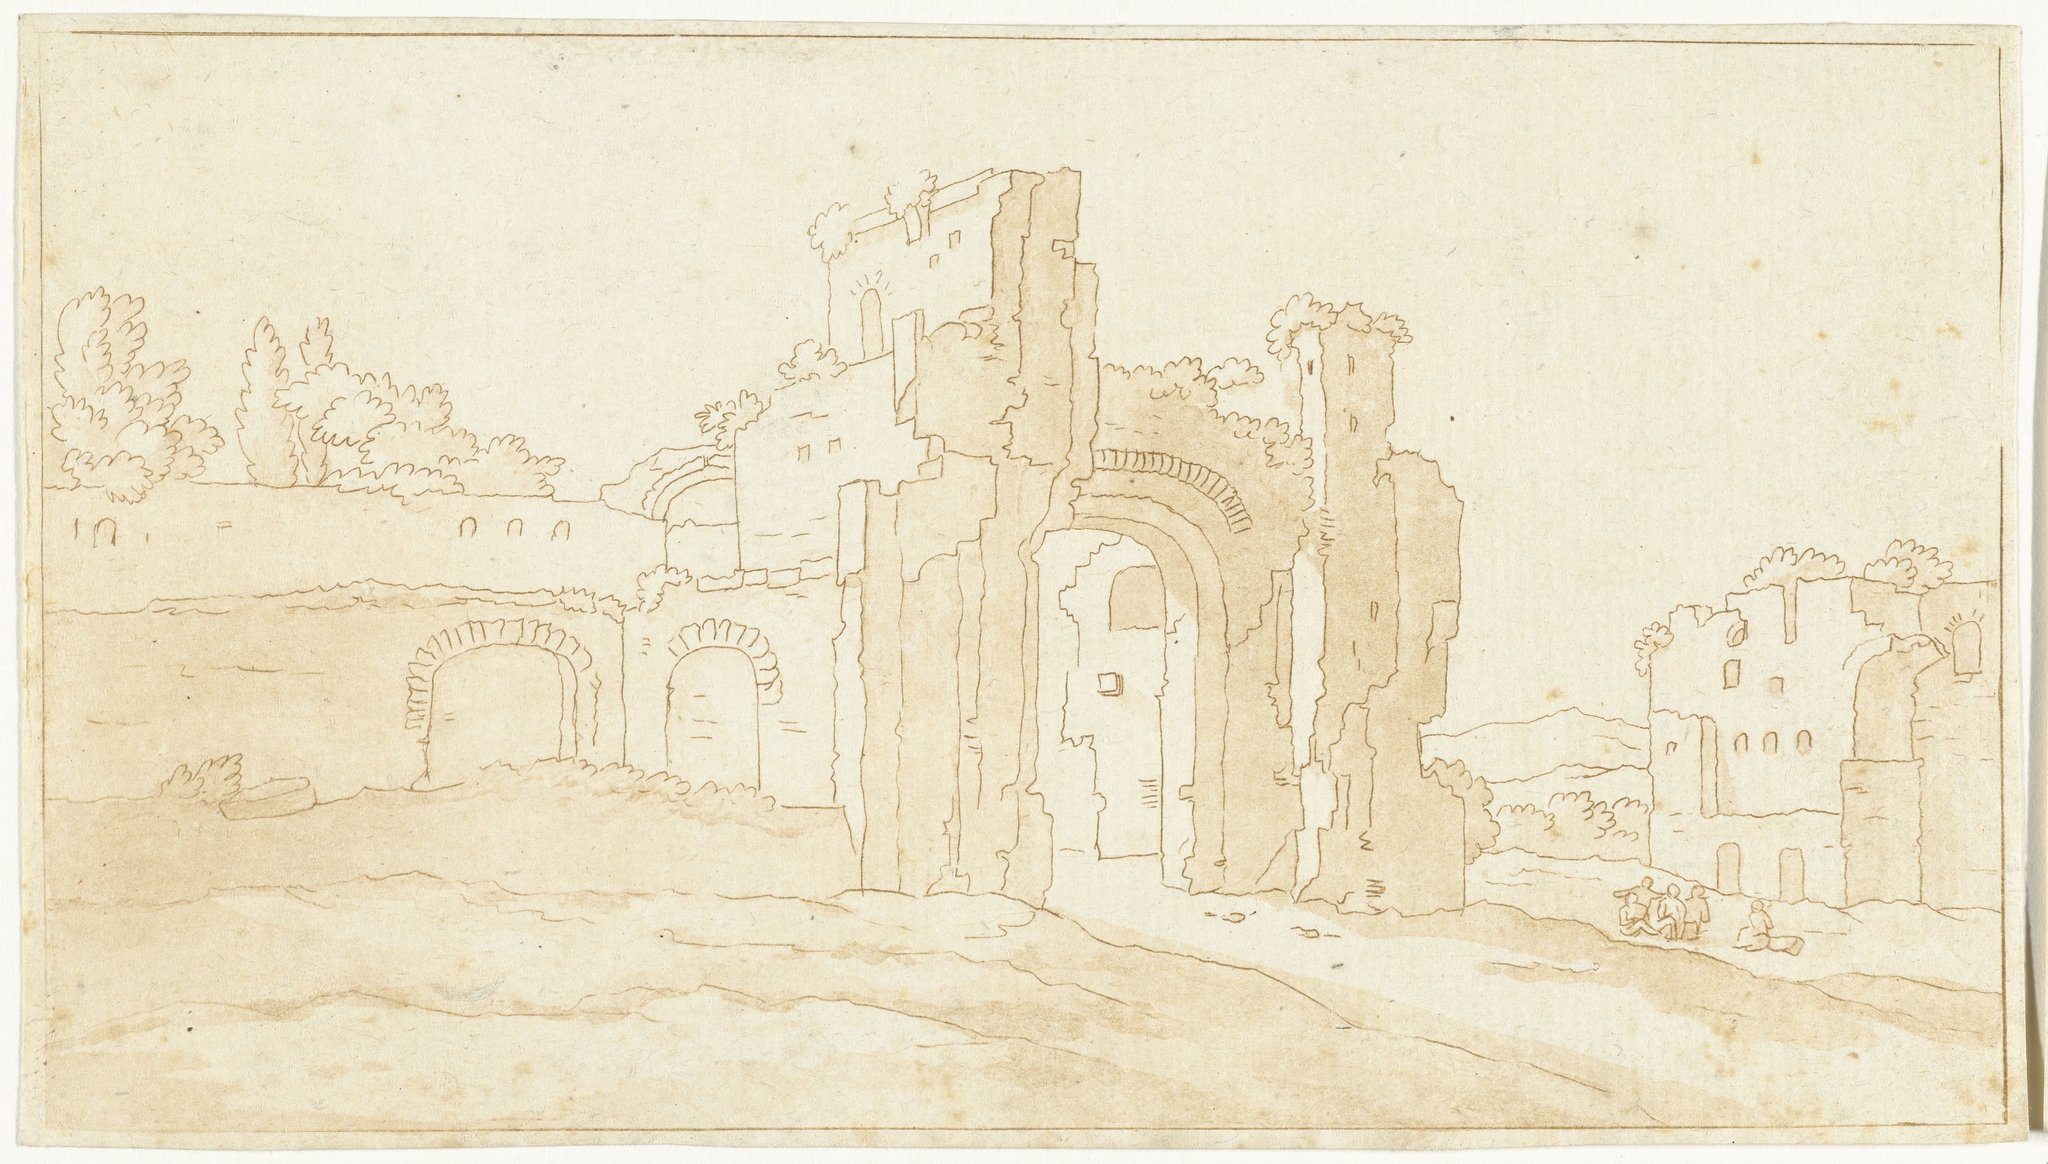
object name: print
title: Ruïnes van de grote zaal van de Thermen van Caracalla, Rome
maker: anthonie van den bos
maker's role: draughtsman, print maker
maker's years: 1763-1838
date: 1778-1838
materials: paper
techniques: printing, printmaking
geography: netherlands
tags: landscape with ruins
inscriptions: collector's mark: Lugt 2228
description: Naar een tekening in Parijs, Fondation Custodia (coll. F. Lugt), Parijs, inv.nr. 6481, fol. 33, met het opschrift 'Therme Antonini' (de Thermen van Caracalla worden in het Latijn 'Thermae Antoninianae' genoemd).